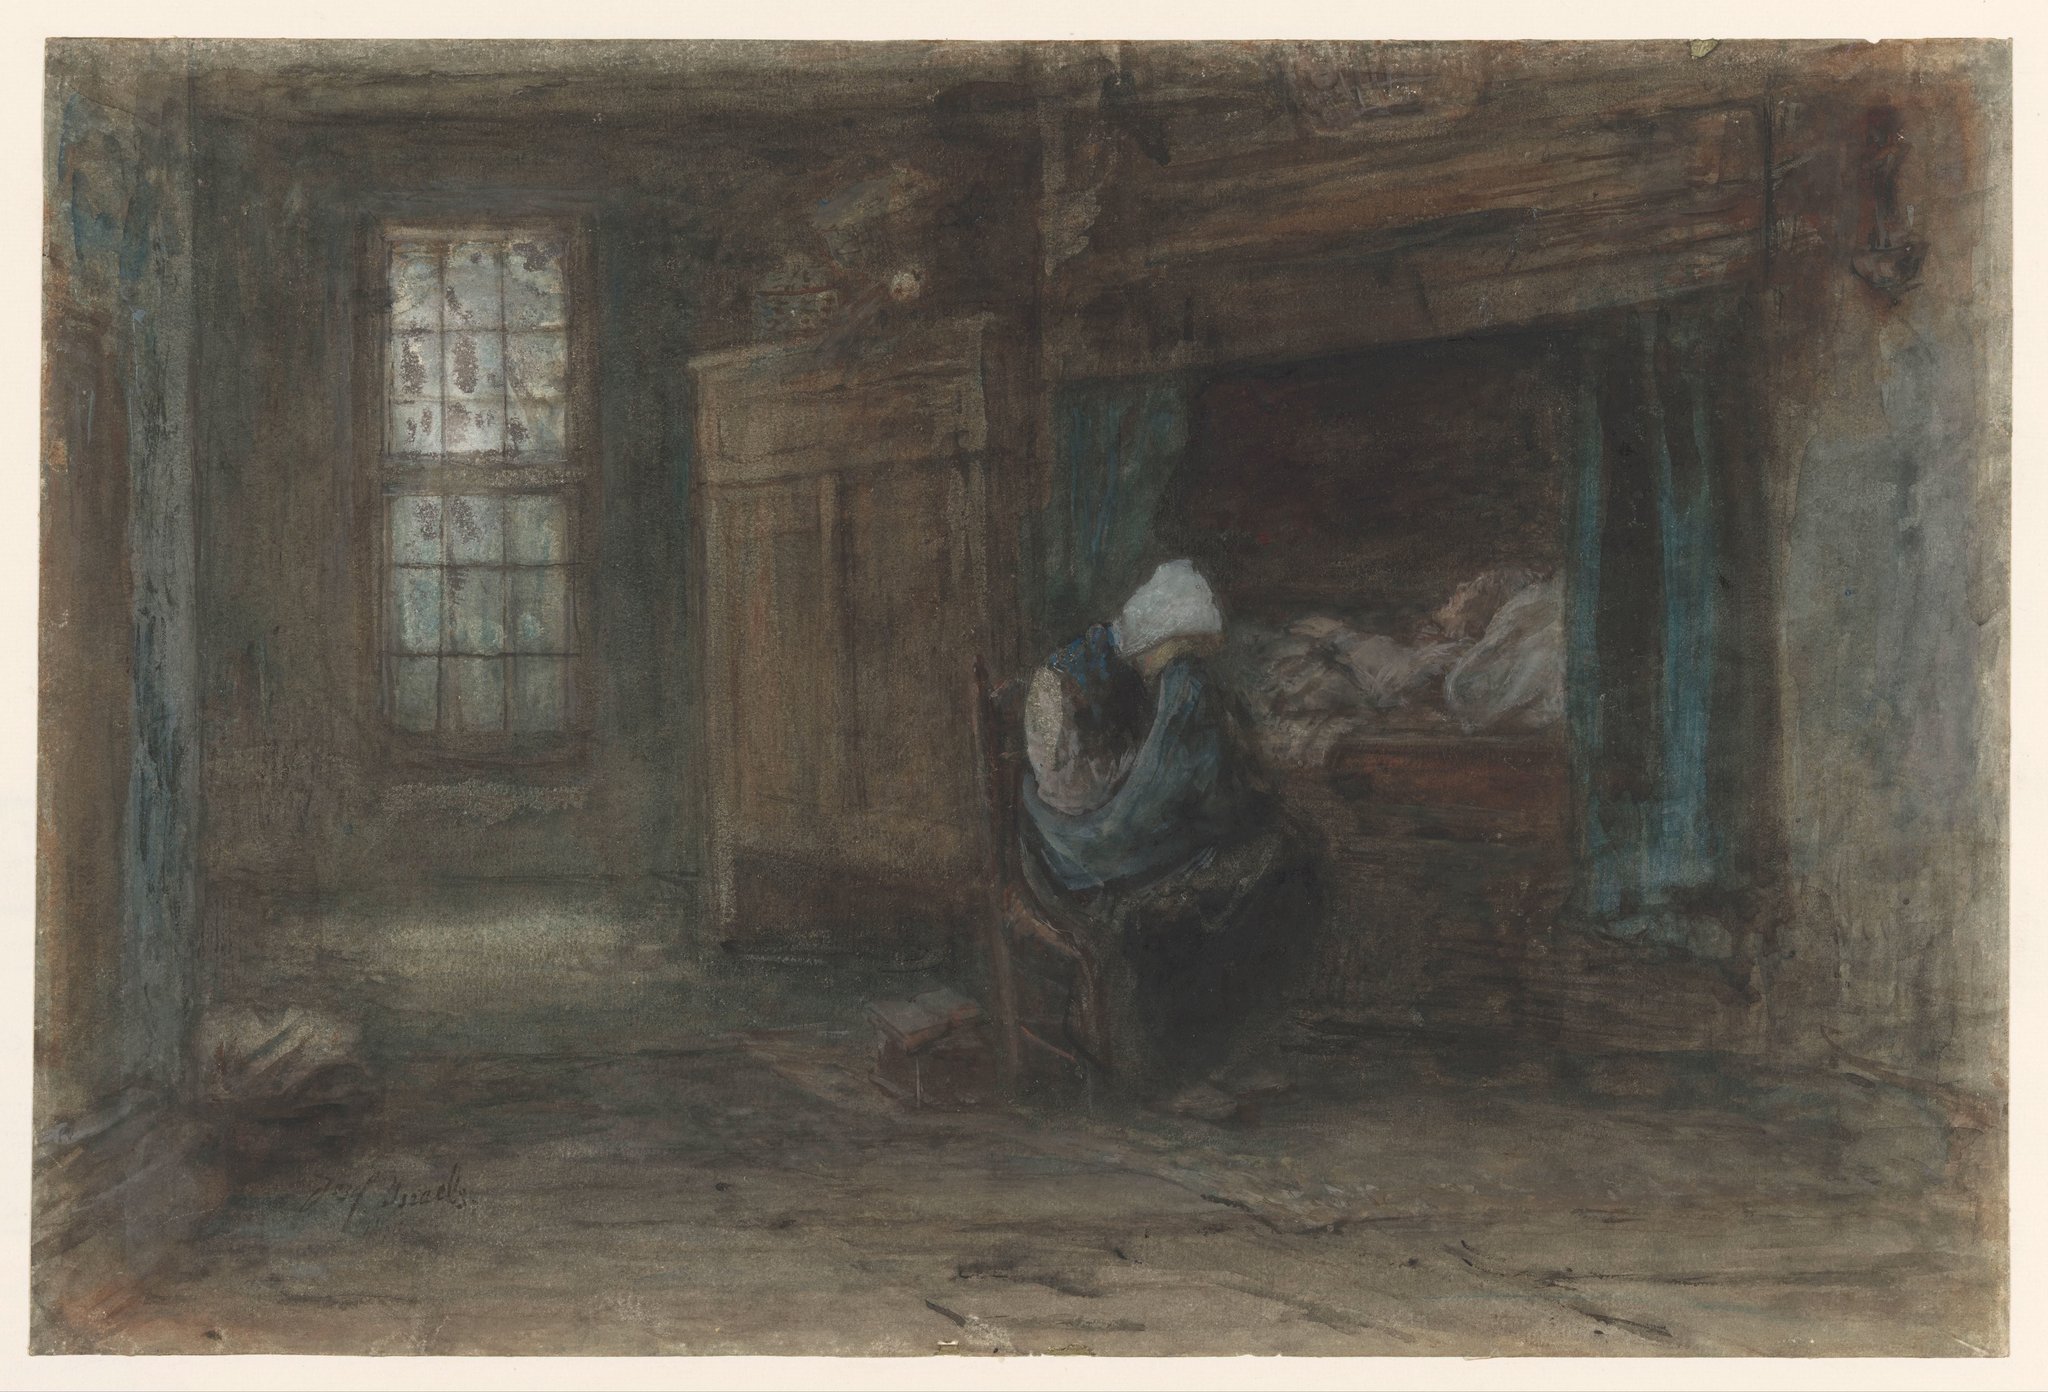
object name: drawing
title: Alleen op de wereld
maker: jozef israëls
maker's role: draughtsman, painter, print maker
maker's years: 1824-1911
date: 1834-1911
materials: paper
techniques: brush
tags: deathbed, mourning the dead, bedroom